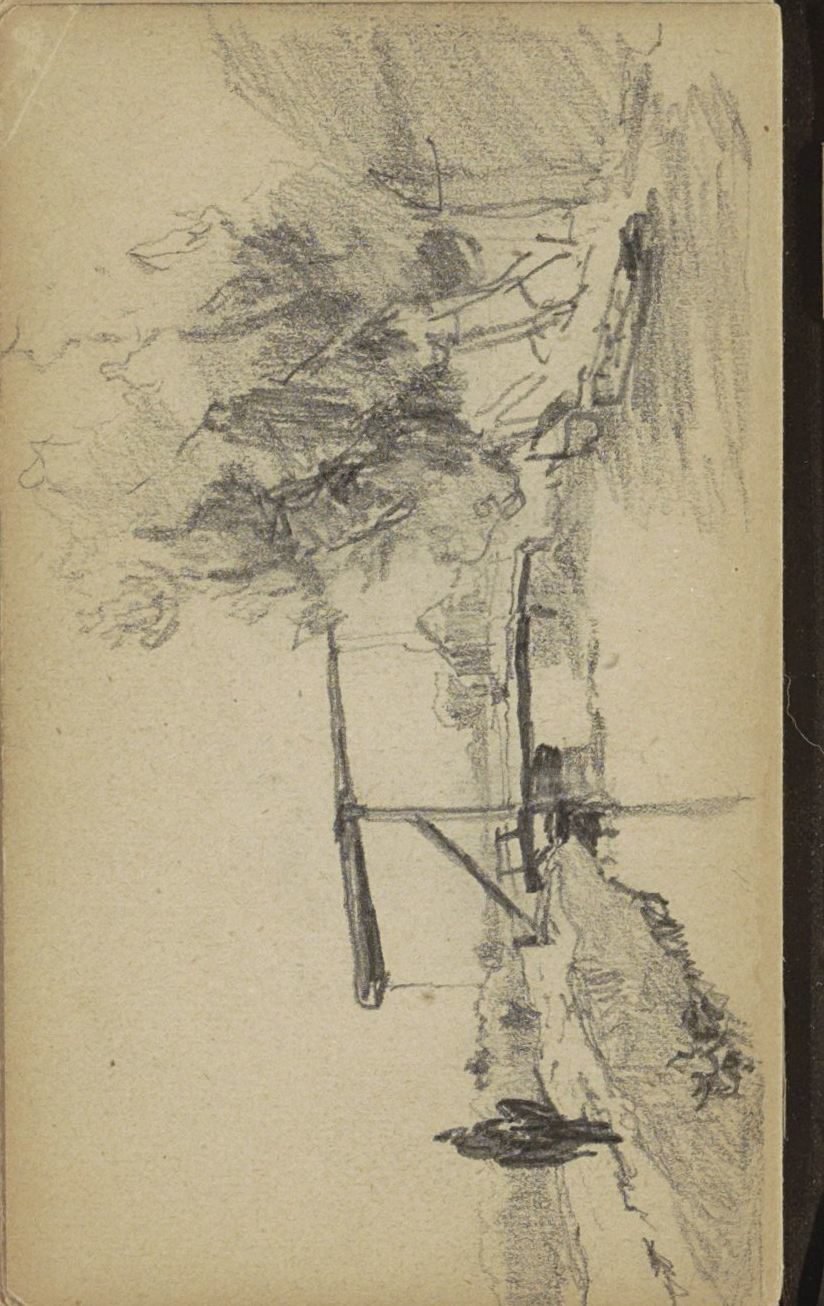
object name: sketchbook leaf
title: Ophaalbrug over een vaart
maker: johan hendrik weissenbruch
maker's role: draughtsman, painter, print maker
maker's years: 1824-1903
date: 1834-1903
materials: paper, pencil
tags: landscapes with waters, waterscapes, seascapes (in the temperate zone), bridge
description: Blad 17 verso uit een schetsboek met 32 bladen.